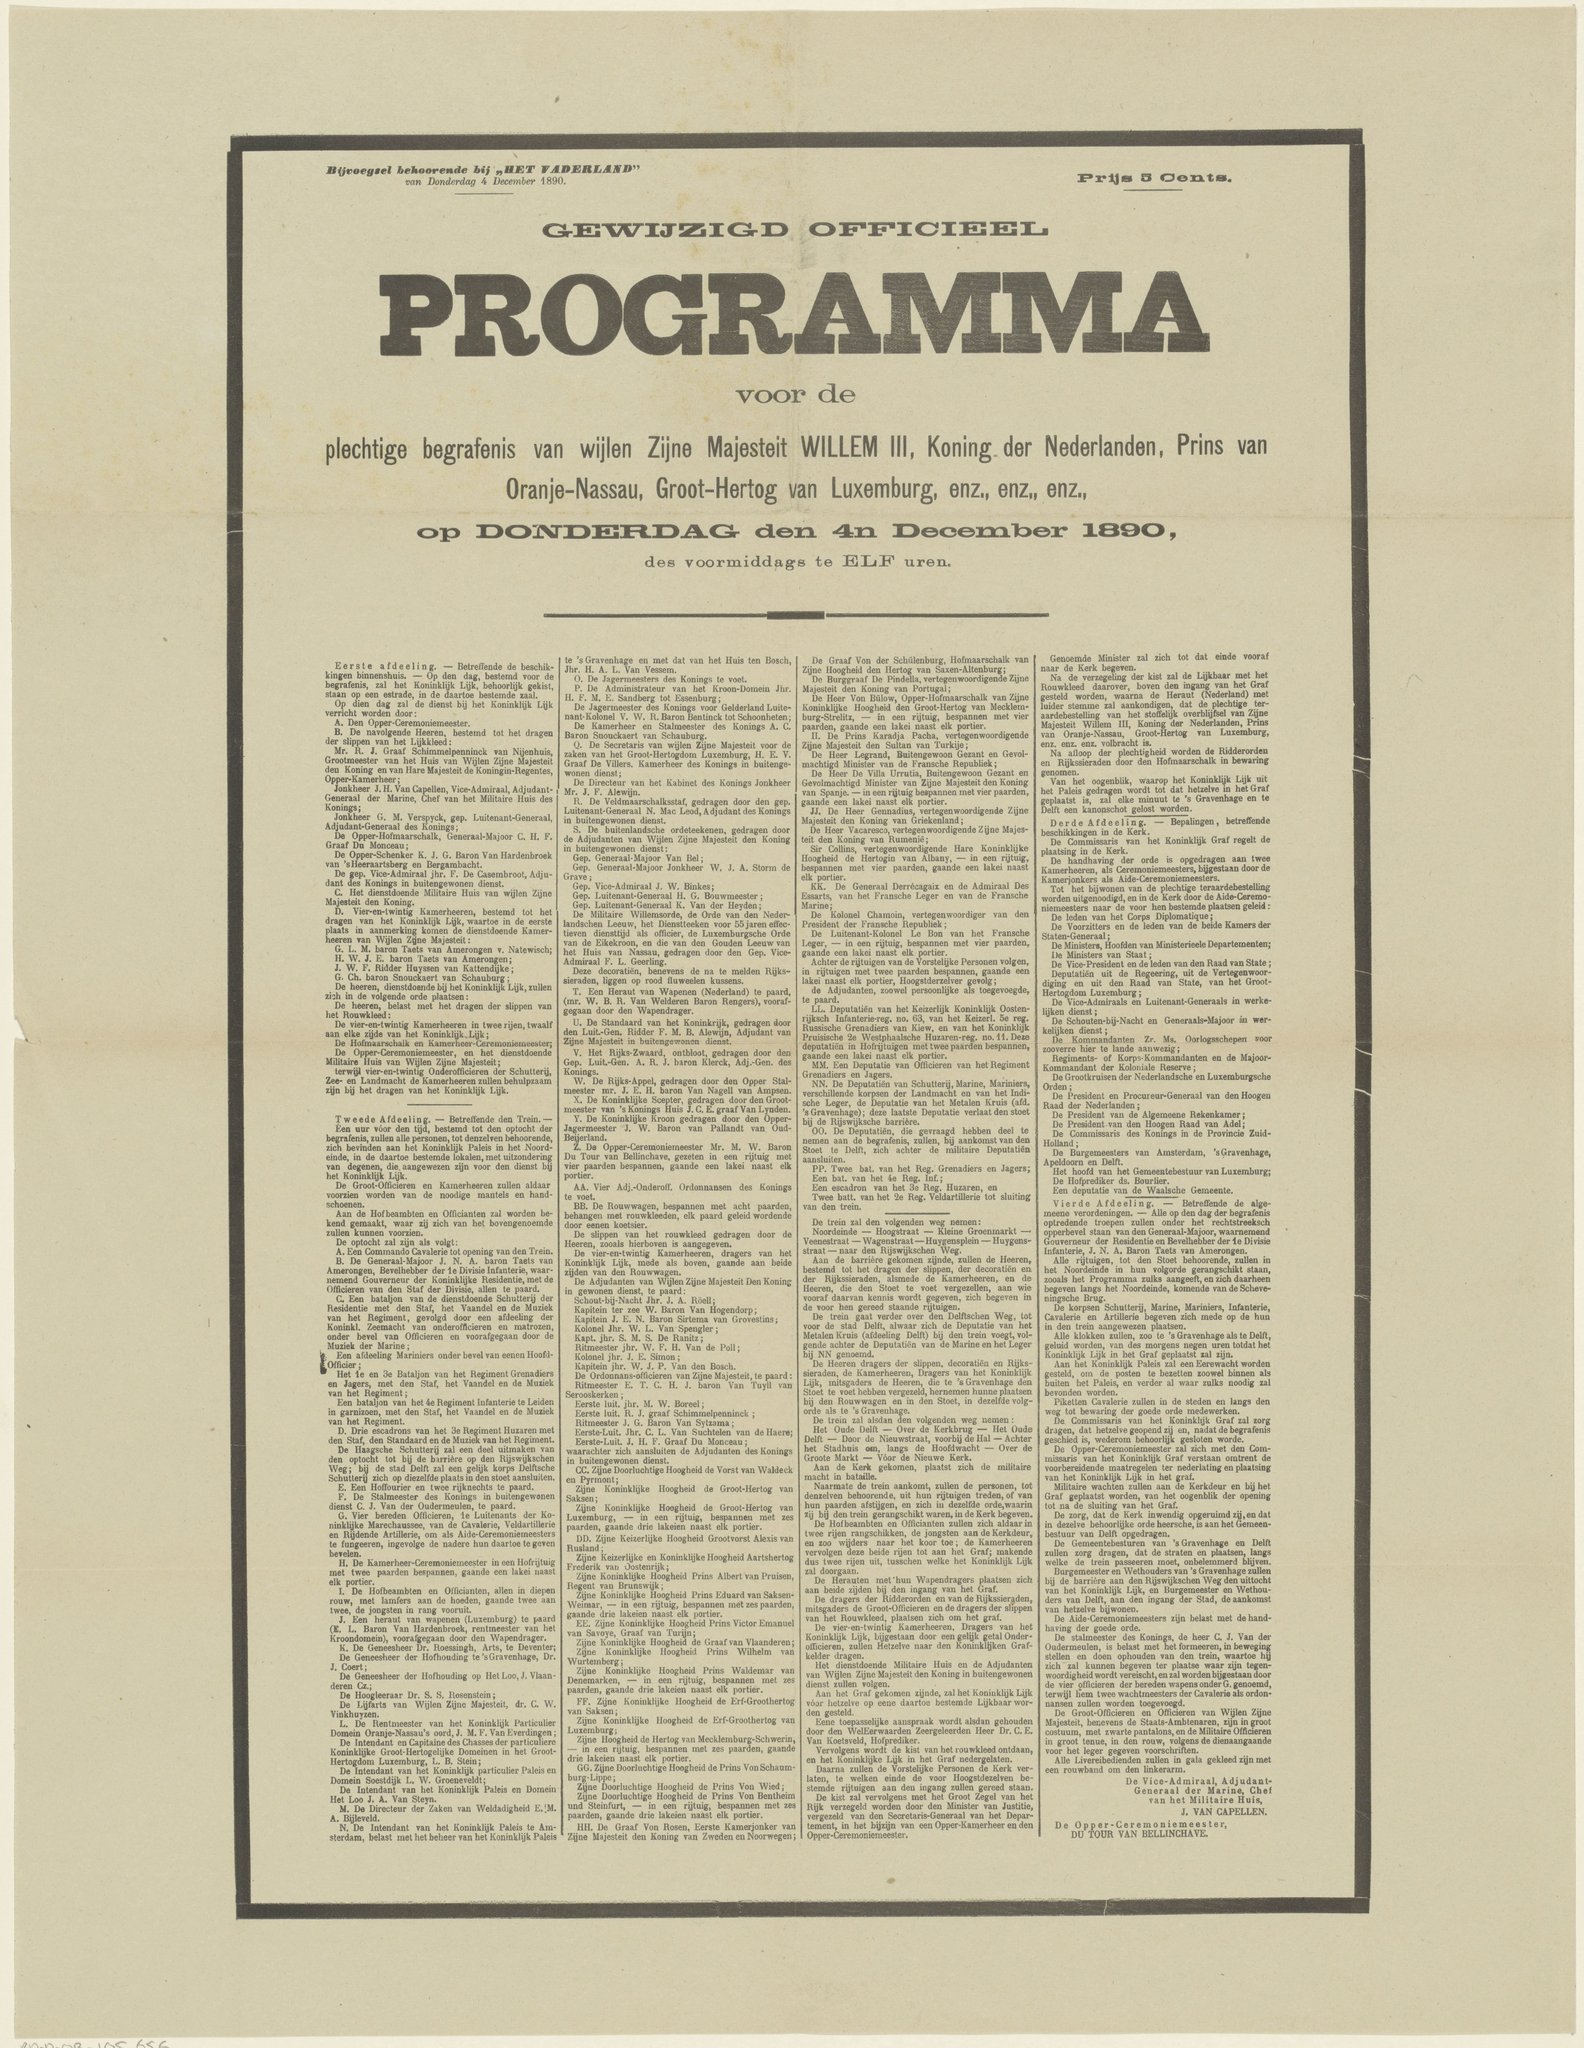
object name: text sheet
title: Programma van de begrafenis van Willem III, koning der Nederlanden, op 4 december 1890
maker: Anonymous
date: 1890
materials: paper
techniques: letterpress printing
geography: netherlands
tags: brussels, willem iii (koning der nederlanden), funerary ceremonial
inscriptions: date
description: Programma van de begrafenis van Willem III op 4 december 1890. Bijvoegsel van 'Het Vaderland'.